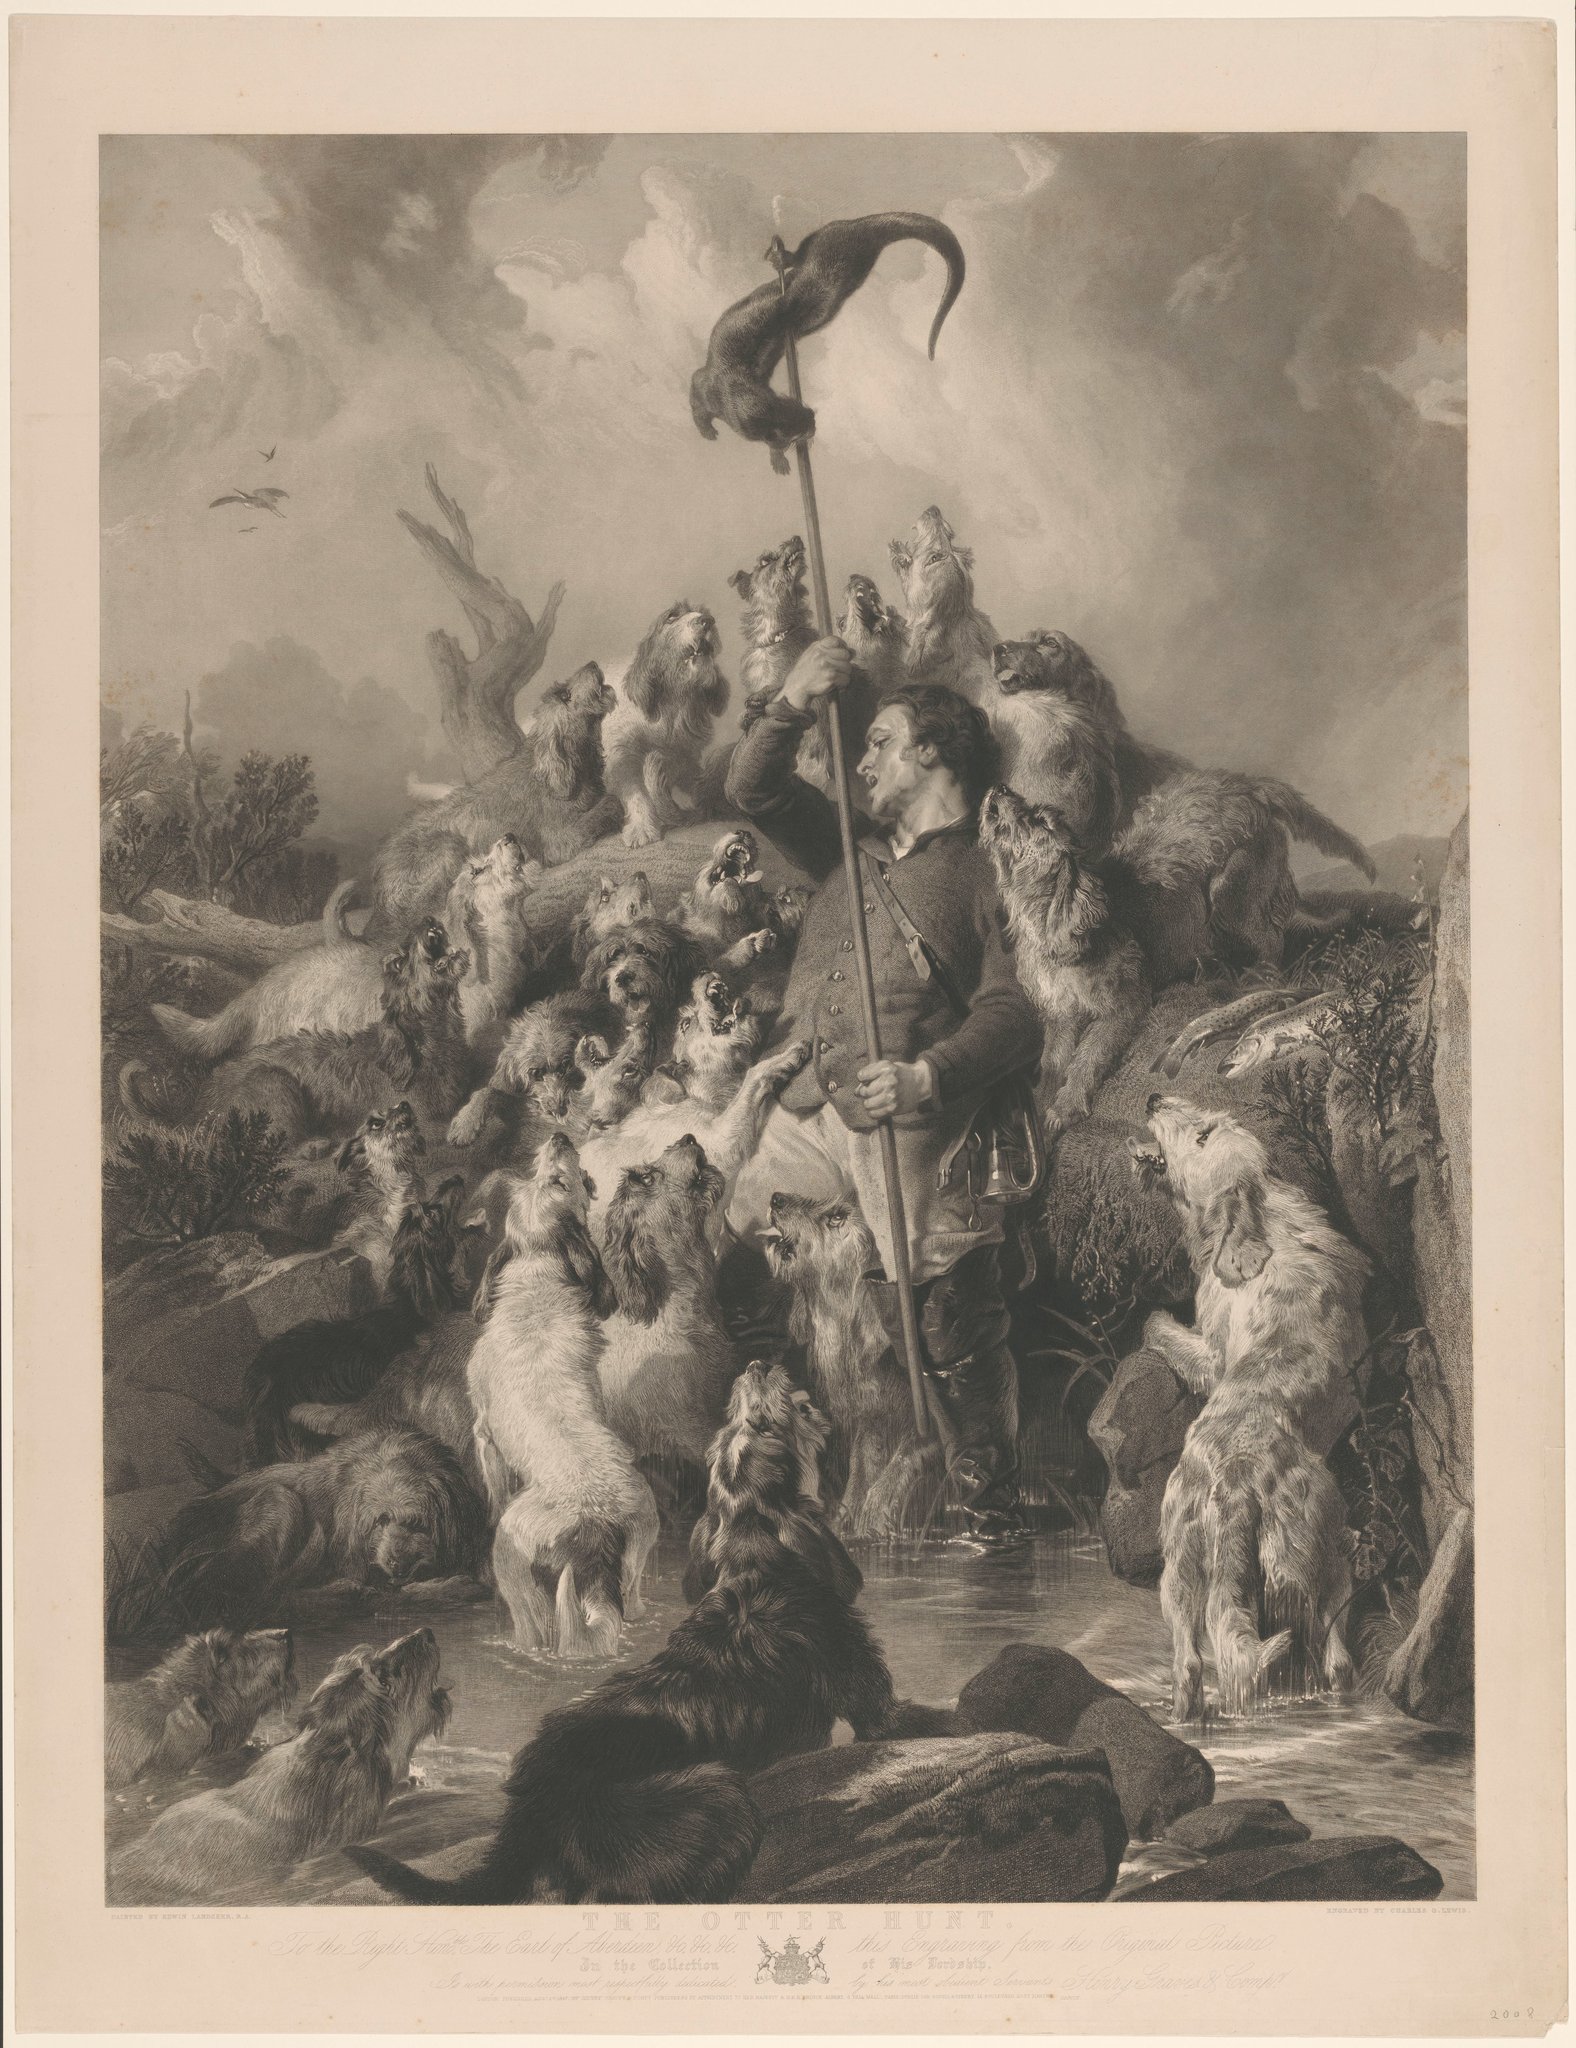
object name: print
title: Jacht op otters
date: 1847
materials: paper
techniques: engraving, etching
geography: london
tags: hunting, chase, beasts of prey, predatory animals: otter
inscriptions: collector's mark: Lugt 2228